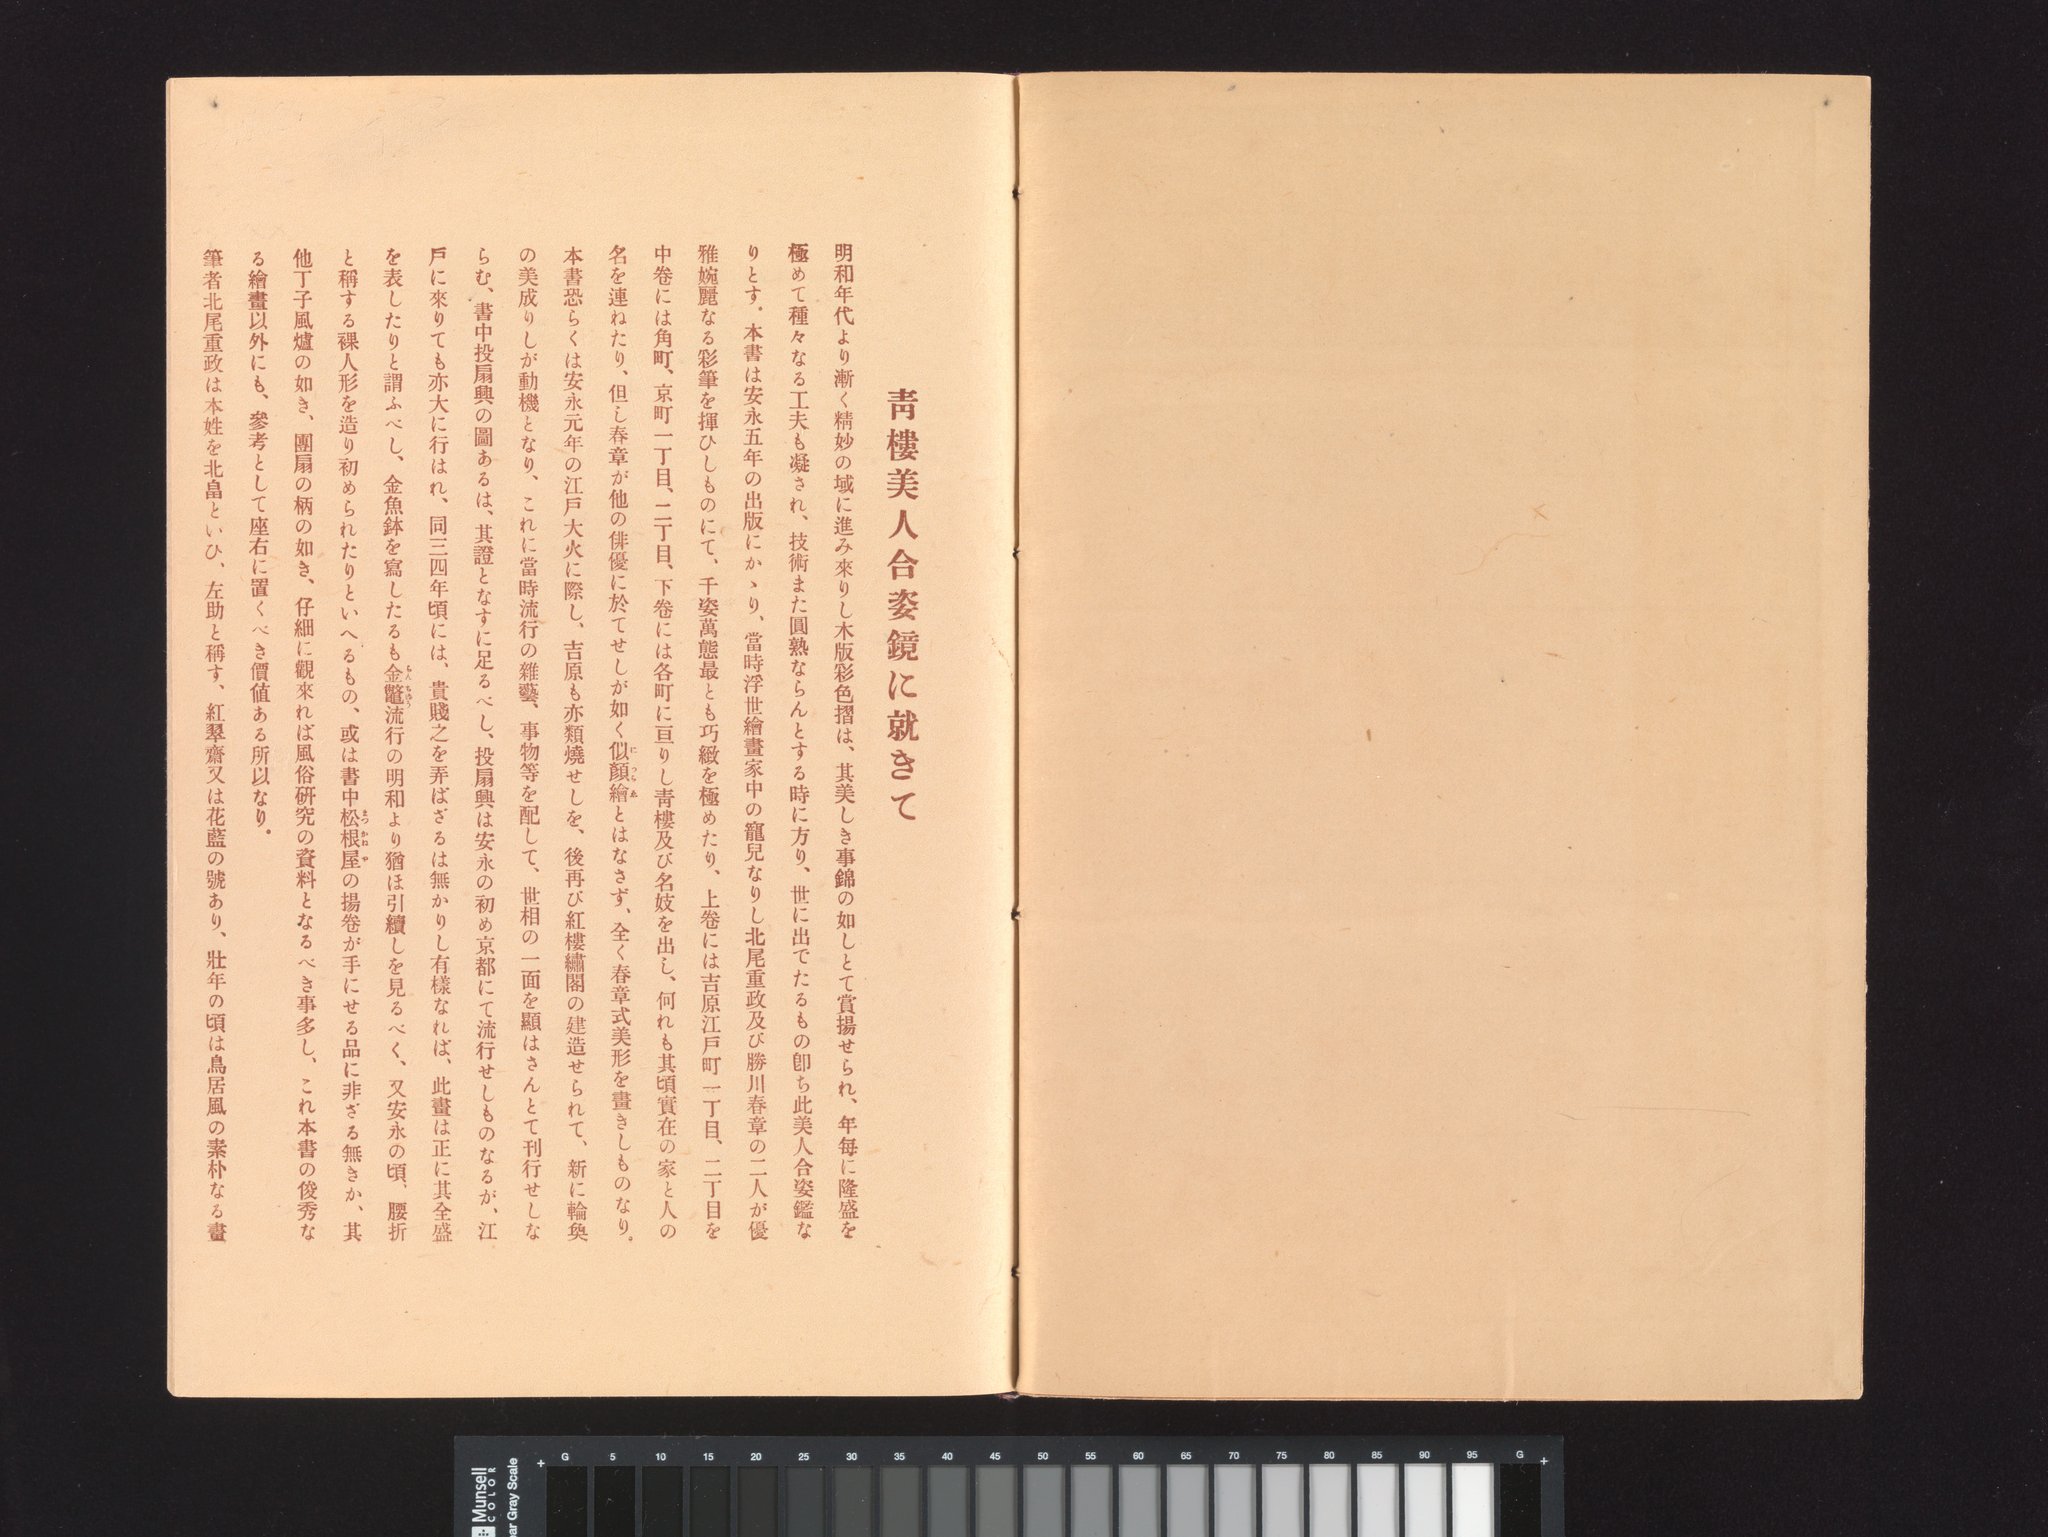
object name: illustrated book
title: A Mirror of Yoshiwara Beauties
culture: japanese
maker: katsukawa shunshō 勝川春章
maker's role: artist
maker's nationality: japanese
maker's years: 1726-1792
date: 1916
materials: ink, paper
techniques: bookbinding, woodblock print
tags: japanese